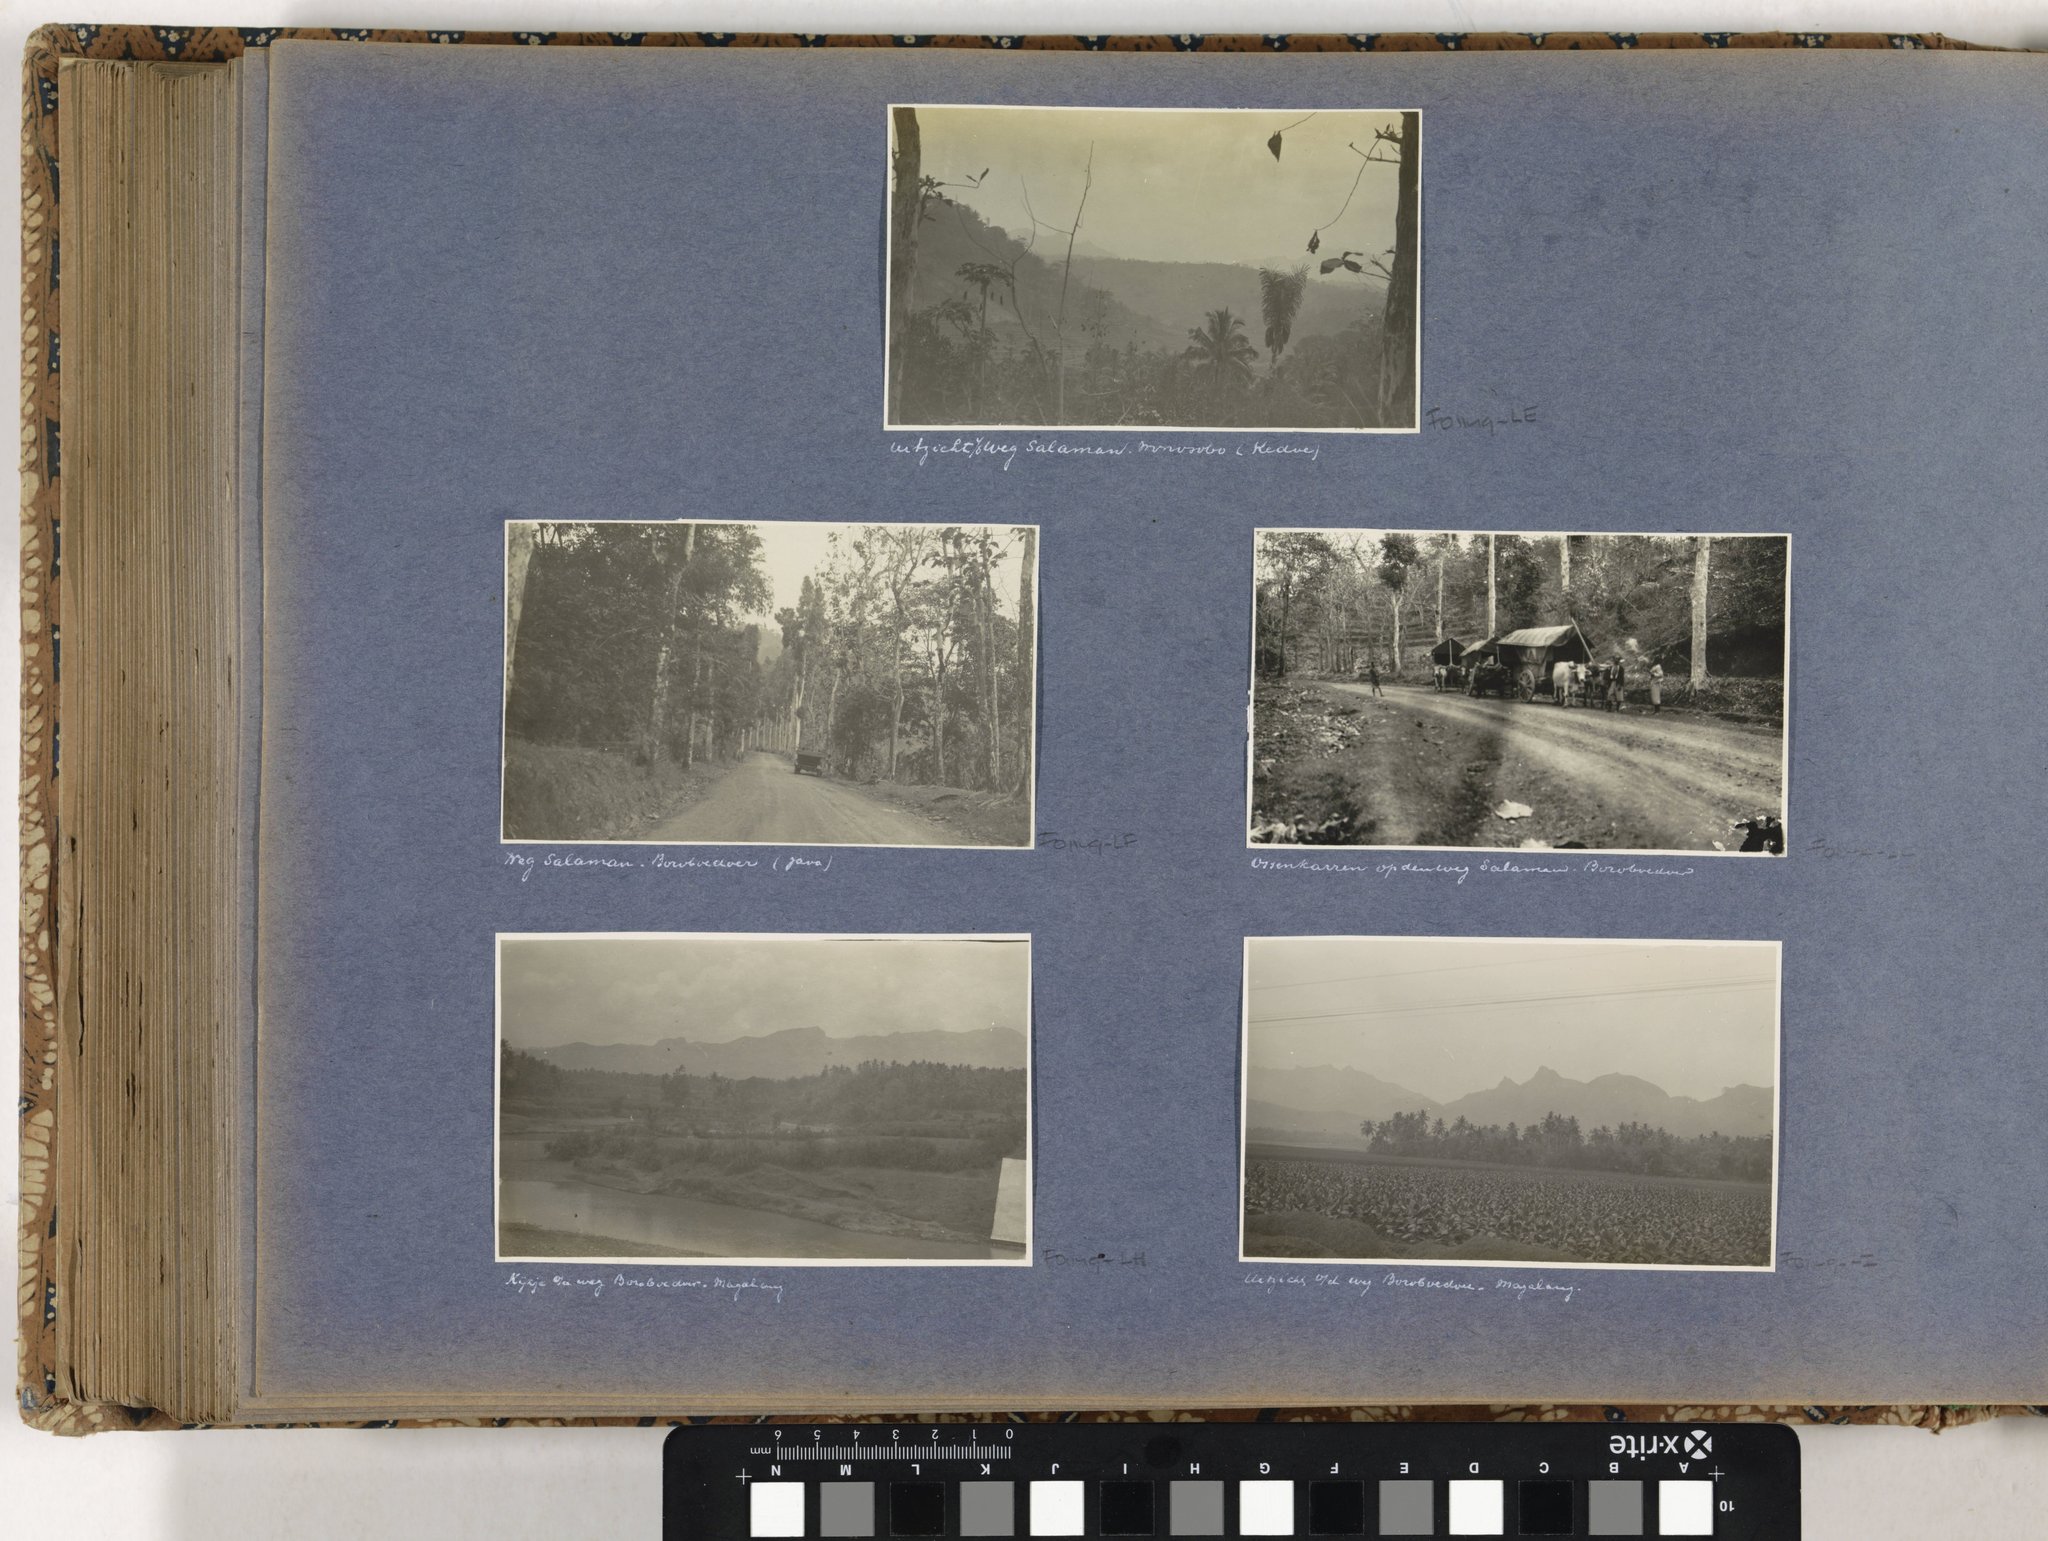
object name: photograph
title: Landschap langs de weg van Salaman naar Borobudur op Java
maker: Anonymous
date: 1900-1920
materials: paper, photographic support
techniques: gelatin silver print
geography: java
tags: mountains (in tropical and sub-tropical regions), java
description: Onderdeel van reisalbum met foto's van bedrijvigheid en bezienswaardigheden op Sumatra en Java en van de reis naar en van Nederlands-Indië.